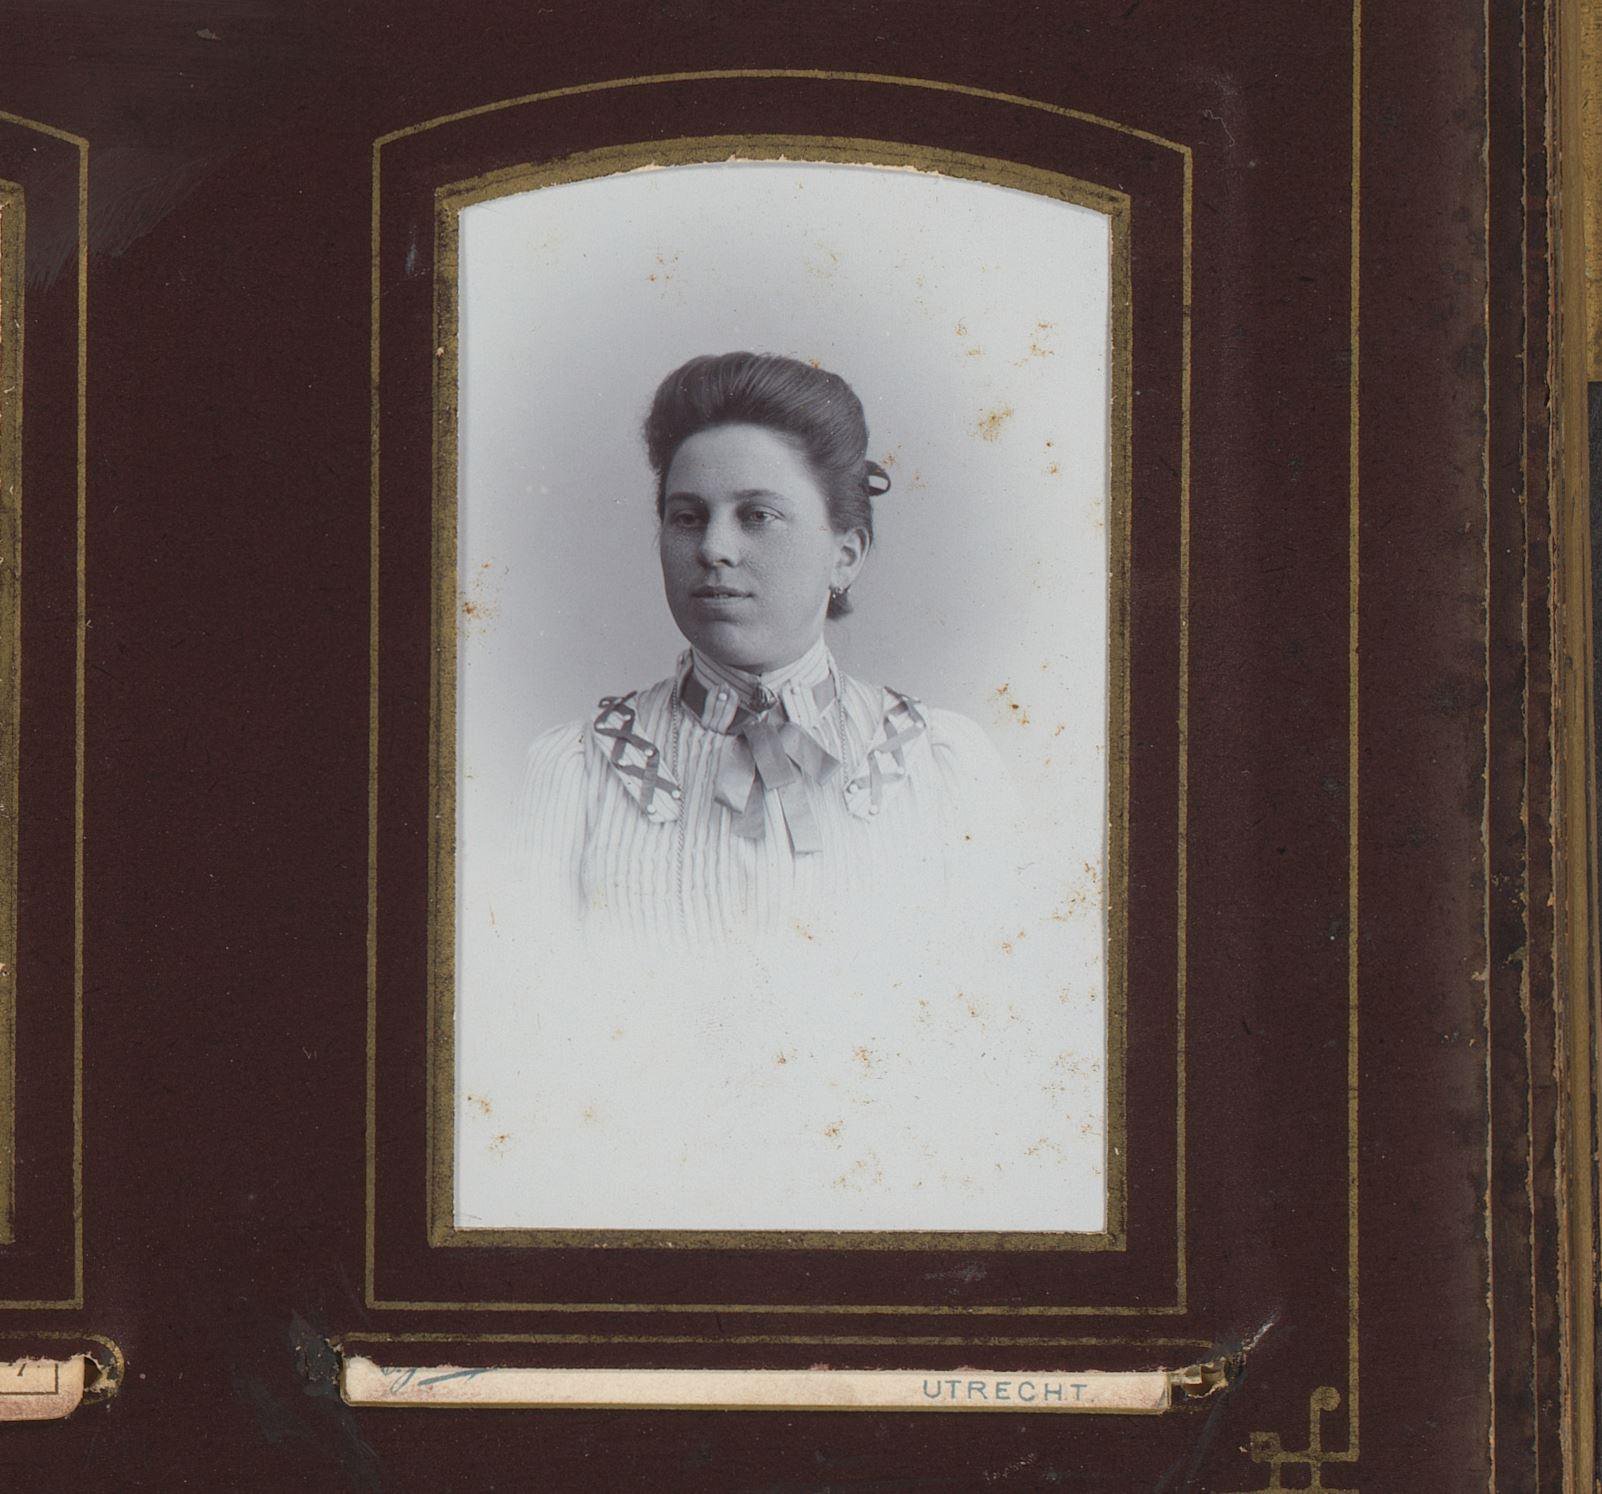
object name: album leaf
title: Portret van een jonge vrouw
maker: cornelis johannes lodewicus vermeulen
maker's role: fotograaf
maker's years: 1861-1936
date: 1878-1915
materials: cardboard, photographic support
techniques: collodion silver print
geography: netherlands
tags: adolescent, young woman, maiden, historical persons - bb - woman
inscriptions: inscription: ‘C.J.L. Vermeulen/ Aden Haag/ Toussaintkade 11./ Intercommunal Telephoon: 774./ Amsterdam/ Heiligenweg hoek Singel./ Telephoon No 2340./ Utrecht/ Nieuwe gracht 50./ Telephoon No 750.’